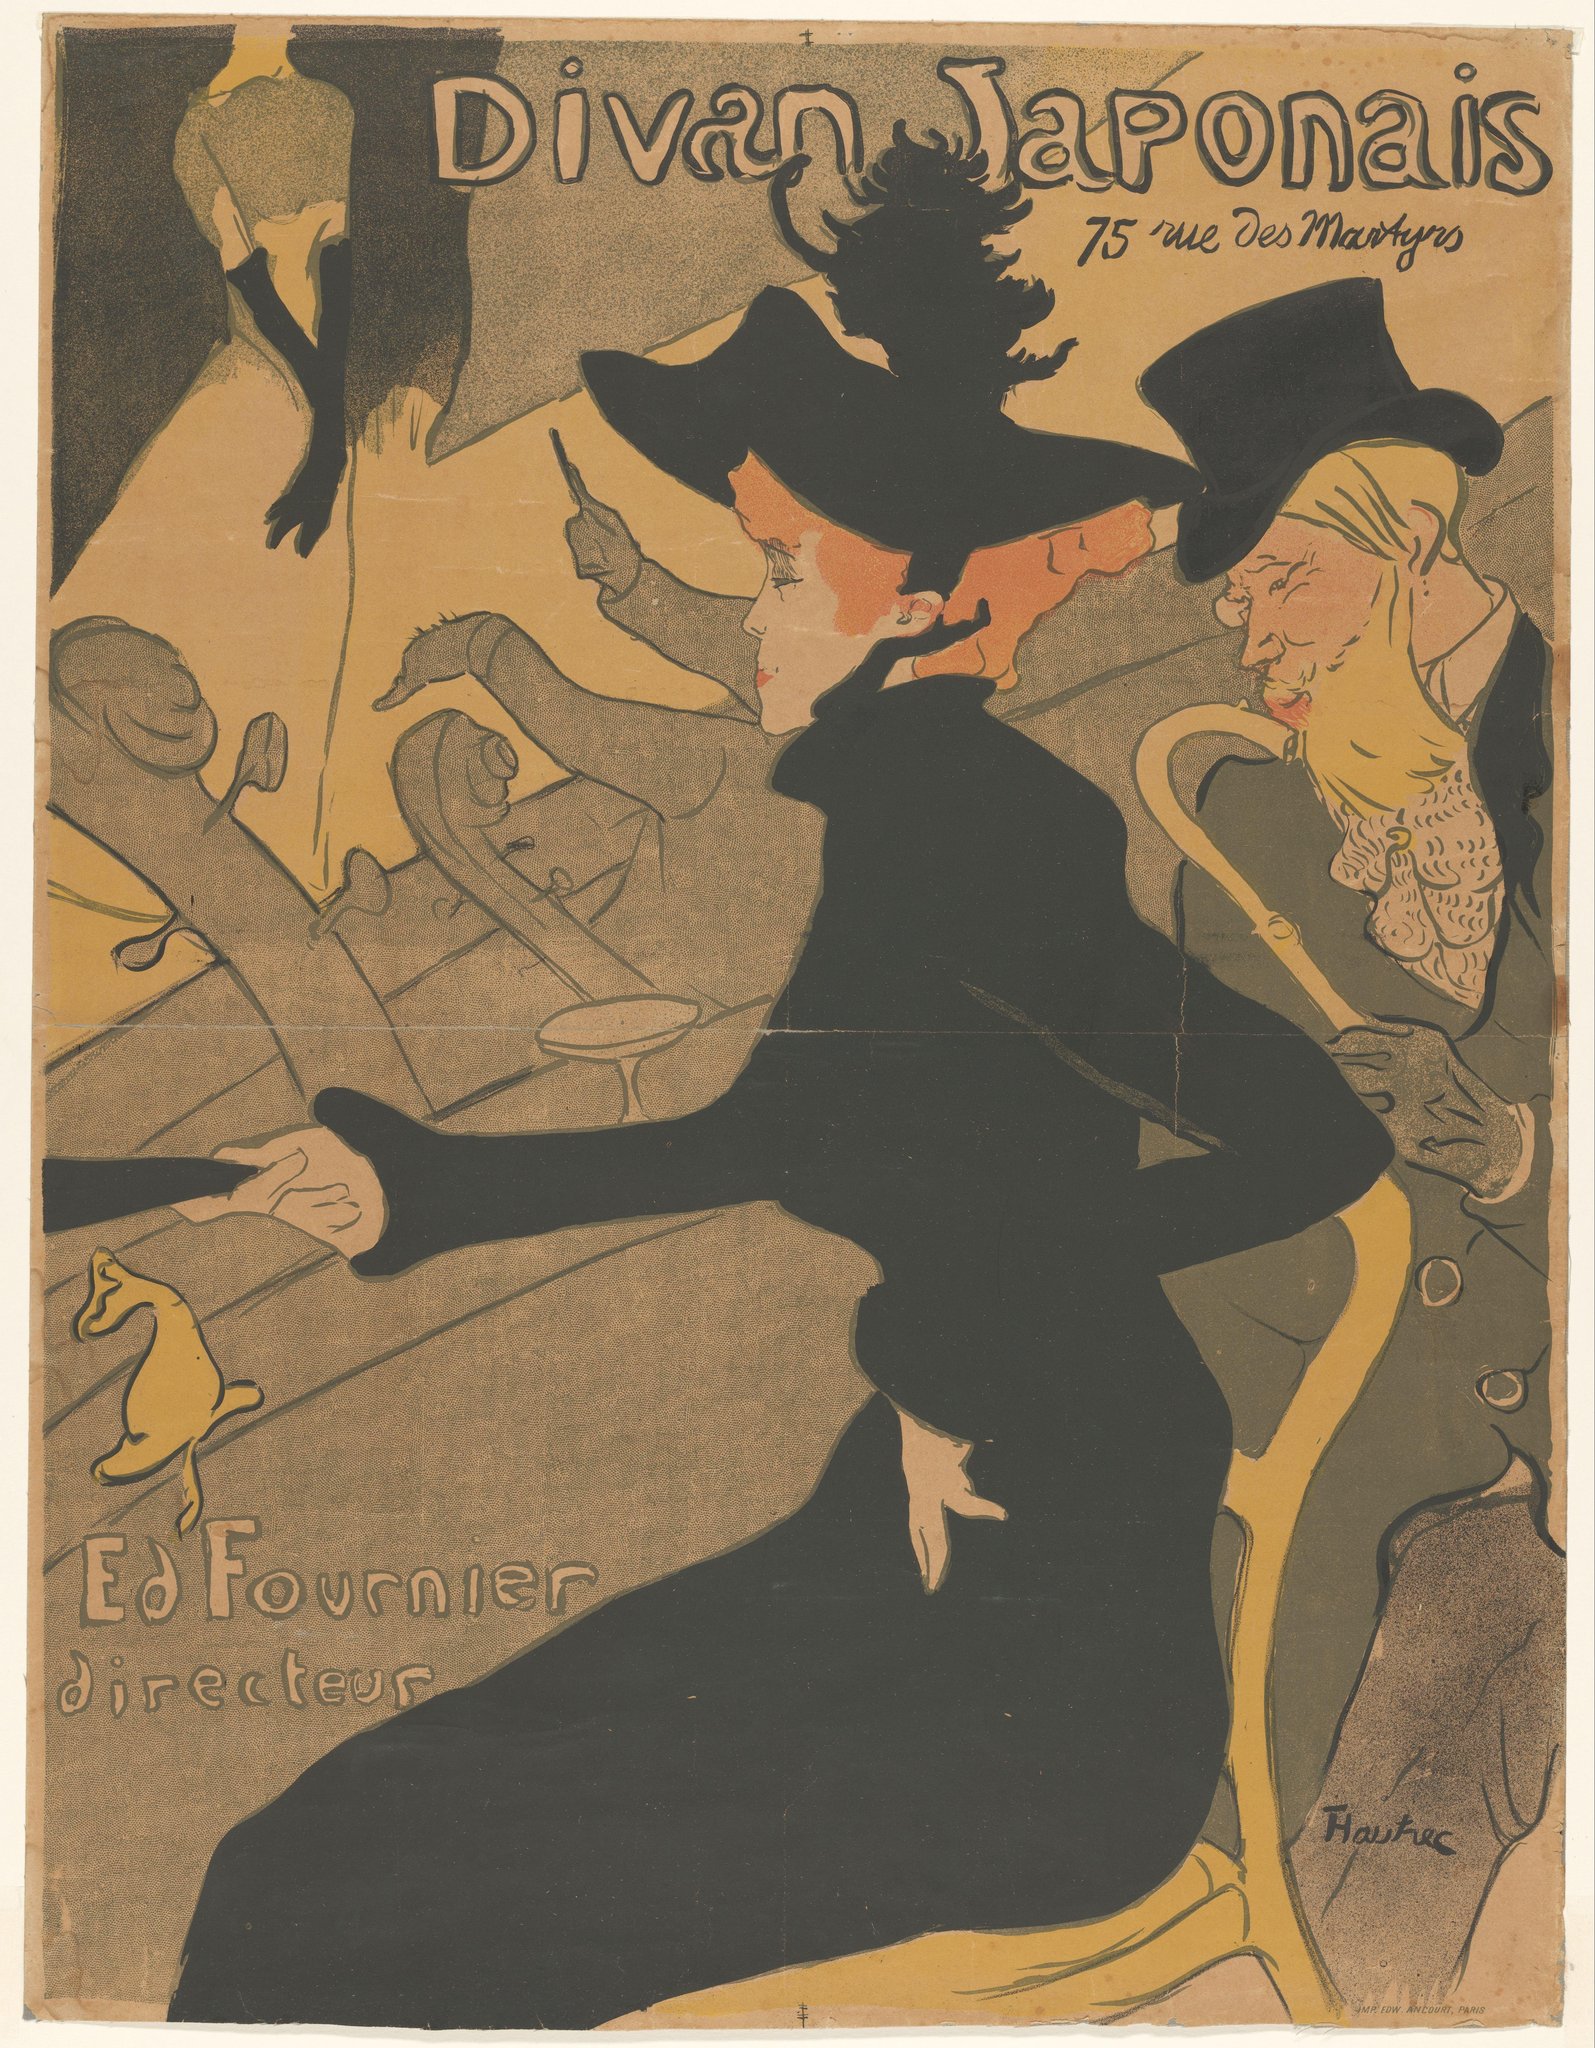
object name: print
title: Divan Japonais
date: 1893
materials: paper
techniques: lithograph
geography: paris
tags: paris, jeanne louise beaudon, antwerp, print maker, edouard dujardin, musician(s) accompanying singer(s)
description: Affiche ter promotie van het Parijse café chantant Divan Japonais. De afgebeelde vrouw is danseres Jane Avril, de man naast haar is schrijver Édouard Dujardin, de vrouw op het podium is zangeres Yvette Guilbert.